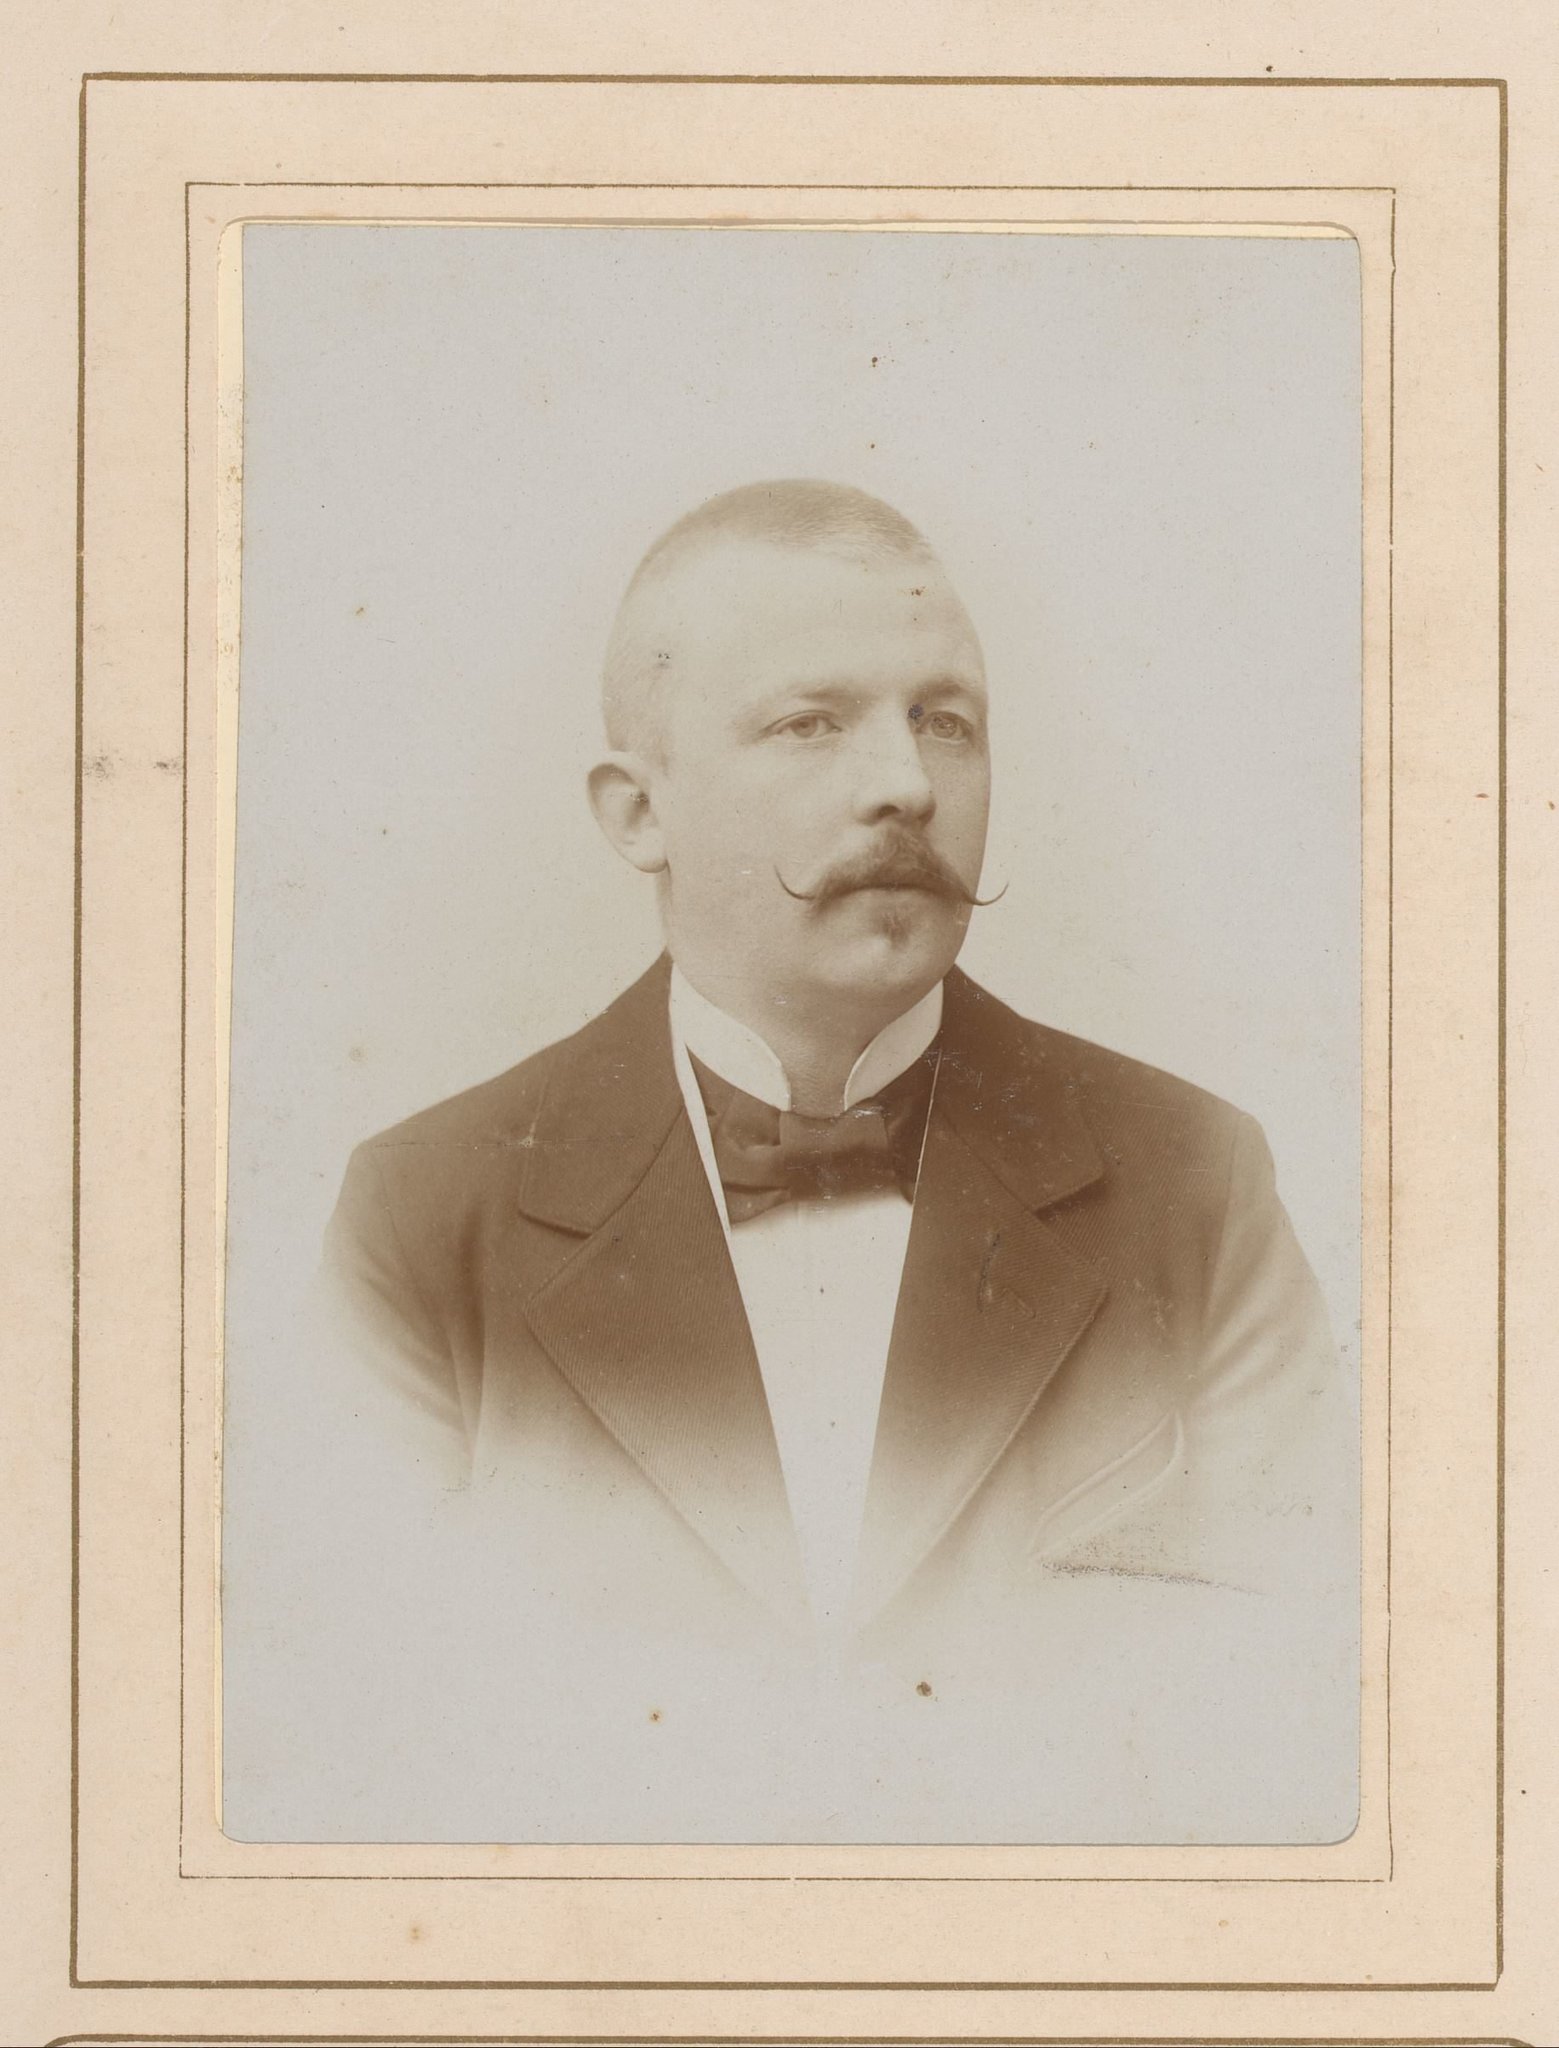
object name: photograph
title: Portret van een man met snor, aangeduid als Dirk de Roever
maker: sander van der zijl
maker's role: fotograaf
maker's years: 1852-1935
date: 1888-1907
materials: cardboard, photographic support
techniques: collodion silver print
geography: amsterdam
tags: moustache, historical persons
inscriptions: name: ‘Dirk de Roever’